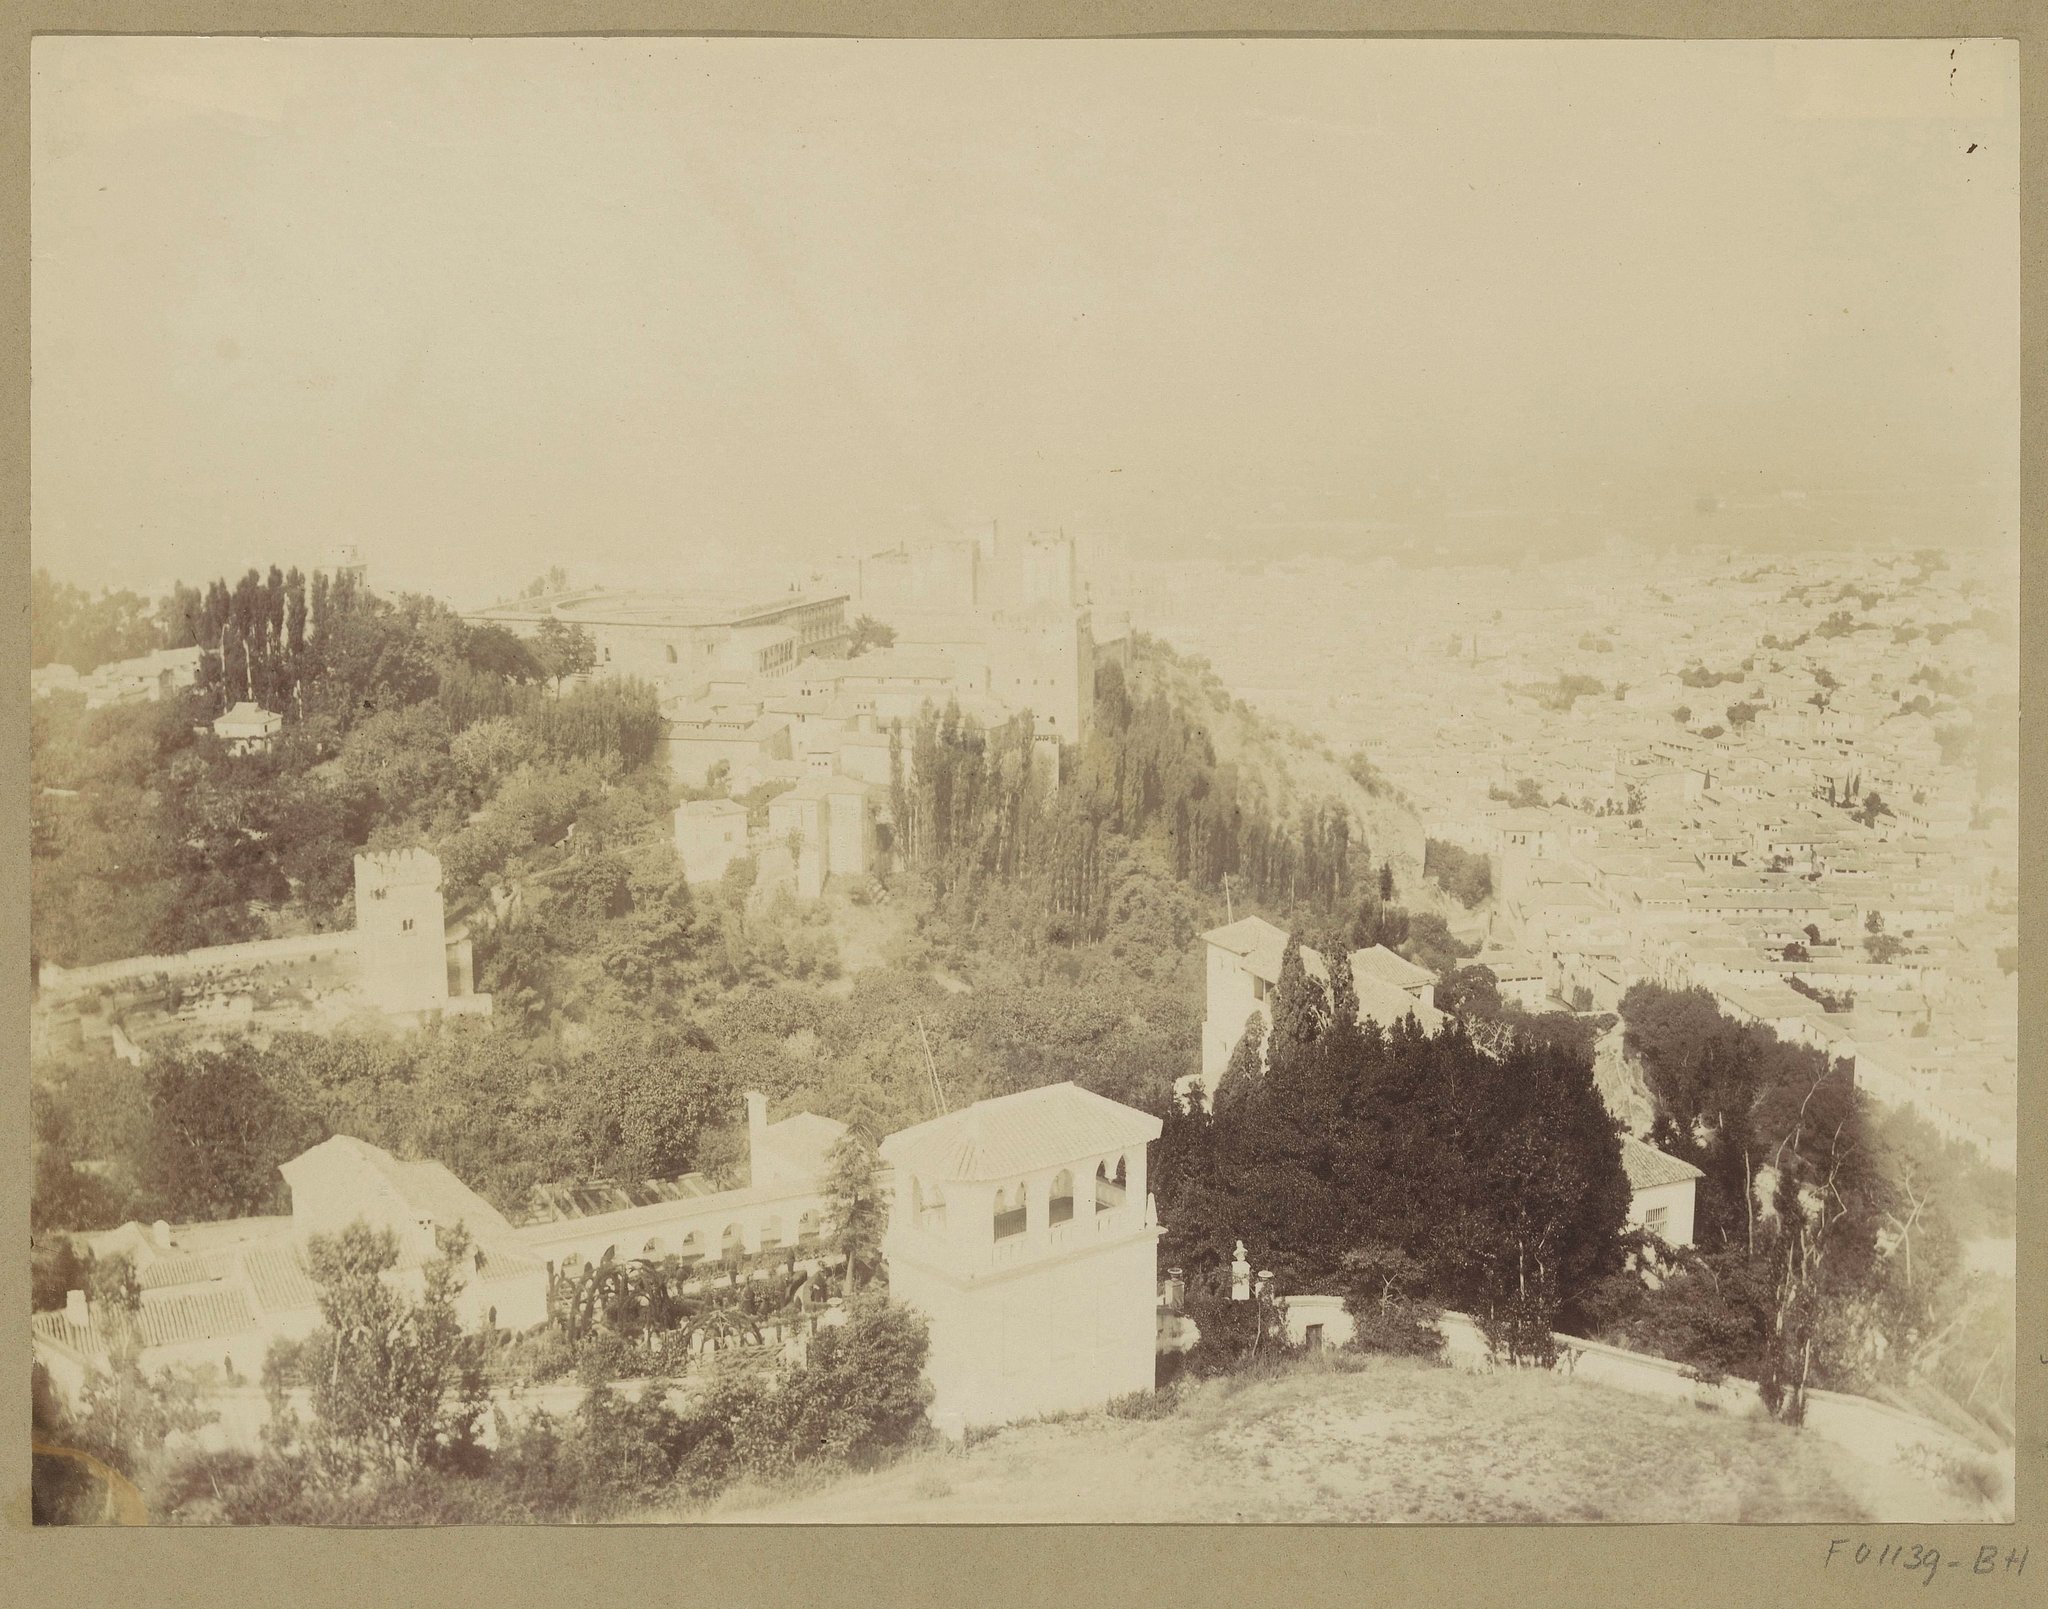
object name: photograph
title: Gezicht op het Alhambra en het Palacio de Generalife in Granada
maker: Anonymous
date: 1851-1890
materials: paper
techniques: albumen print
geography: granada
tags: city-view in general; 'veduta'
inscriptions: inscription: ‘Alhambra/ +/ Generalife’